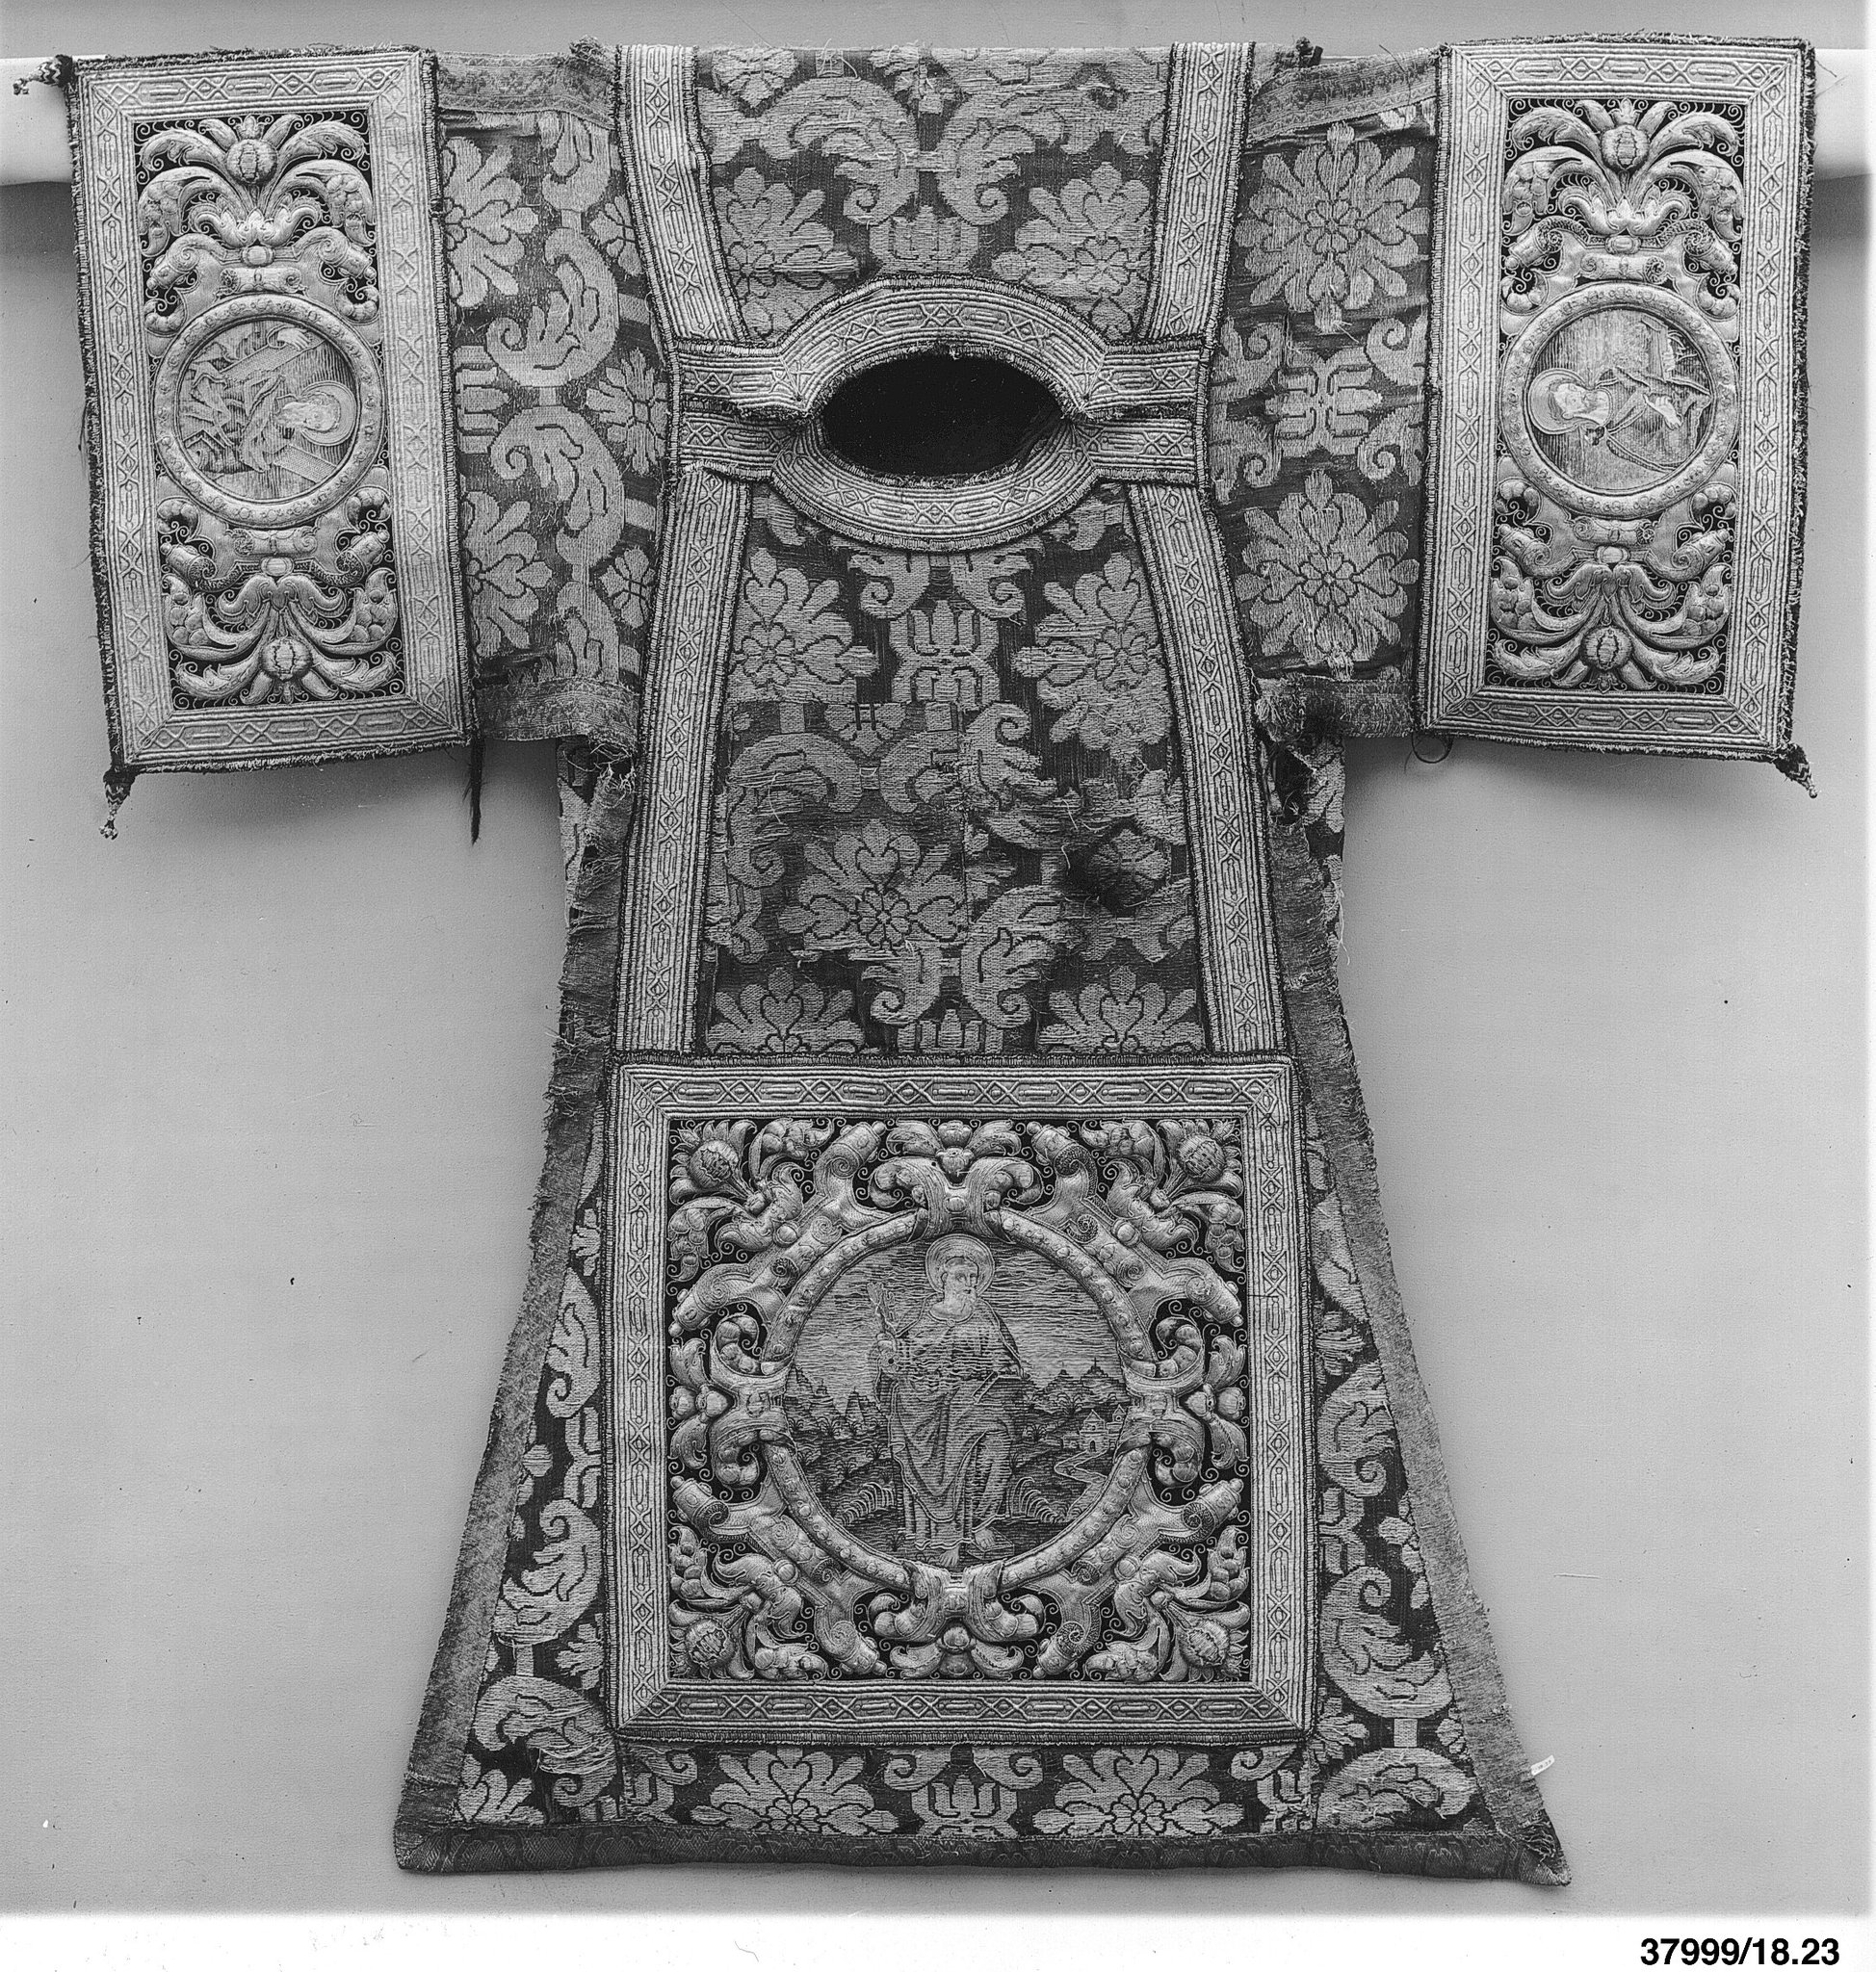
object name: dalmatic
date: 1501-1600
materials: metal thread, silk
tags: flowers,jesus